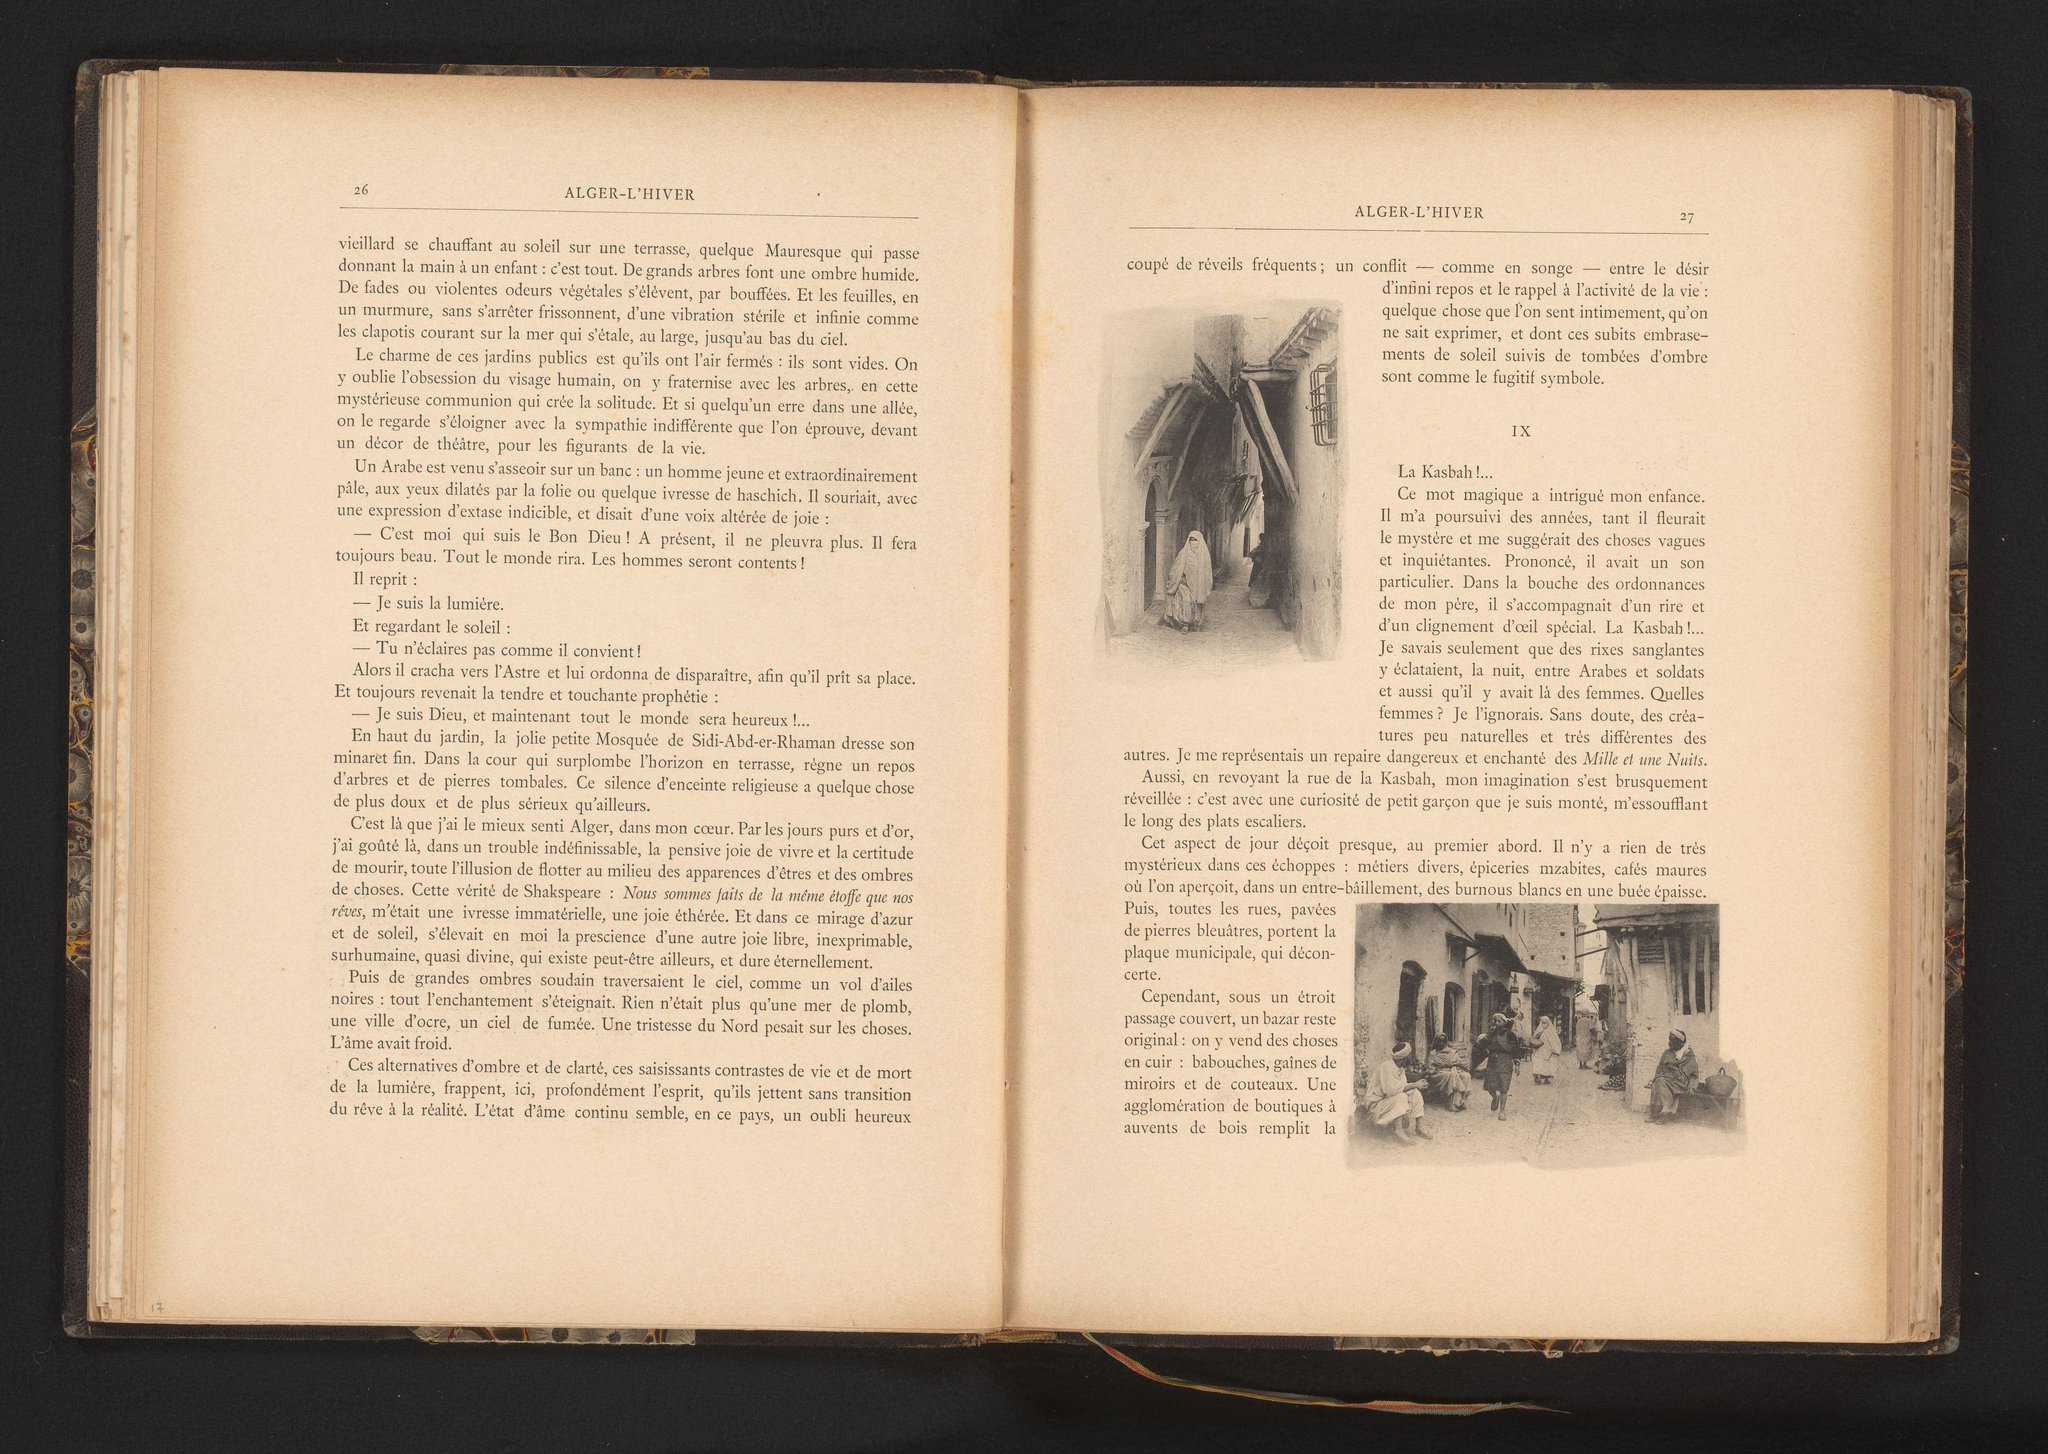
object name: page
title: Vrouw in een straat in de kasba van Algiers, Algerije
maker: jules gervais-courtellemont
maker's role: fotograaf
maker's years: 1863-1931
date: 1888-1893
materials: paper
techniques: photograph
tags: adult woman, street